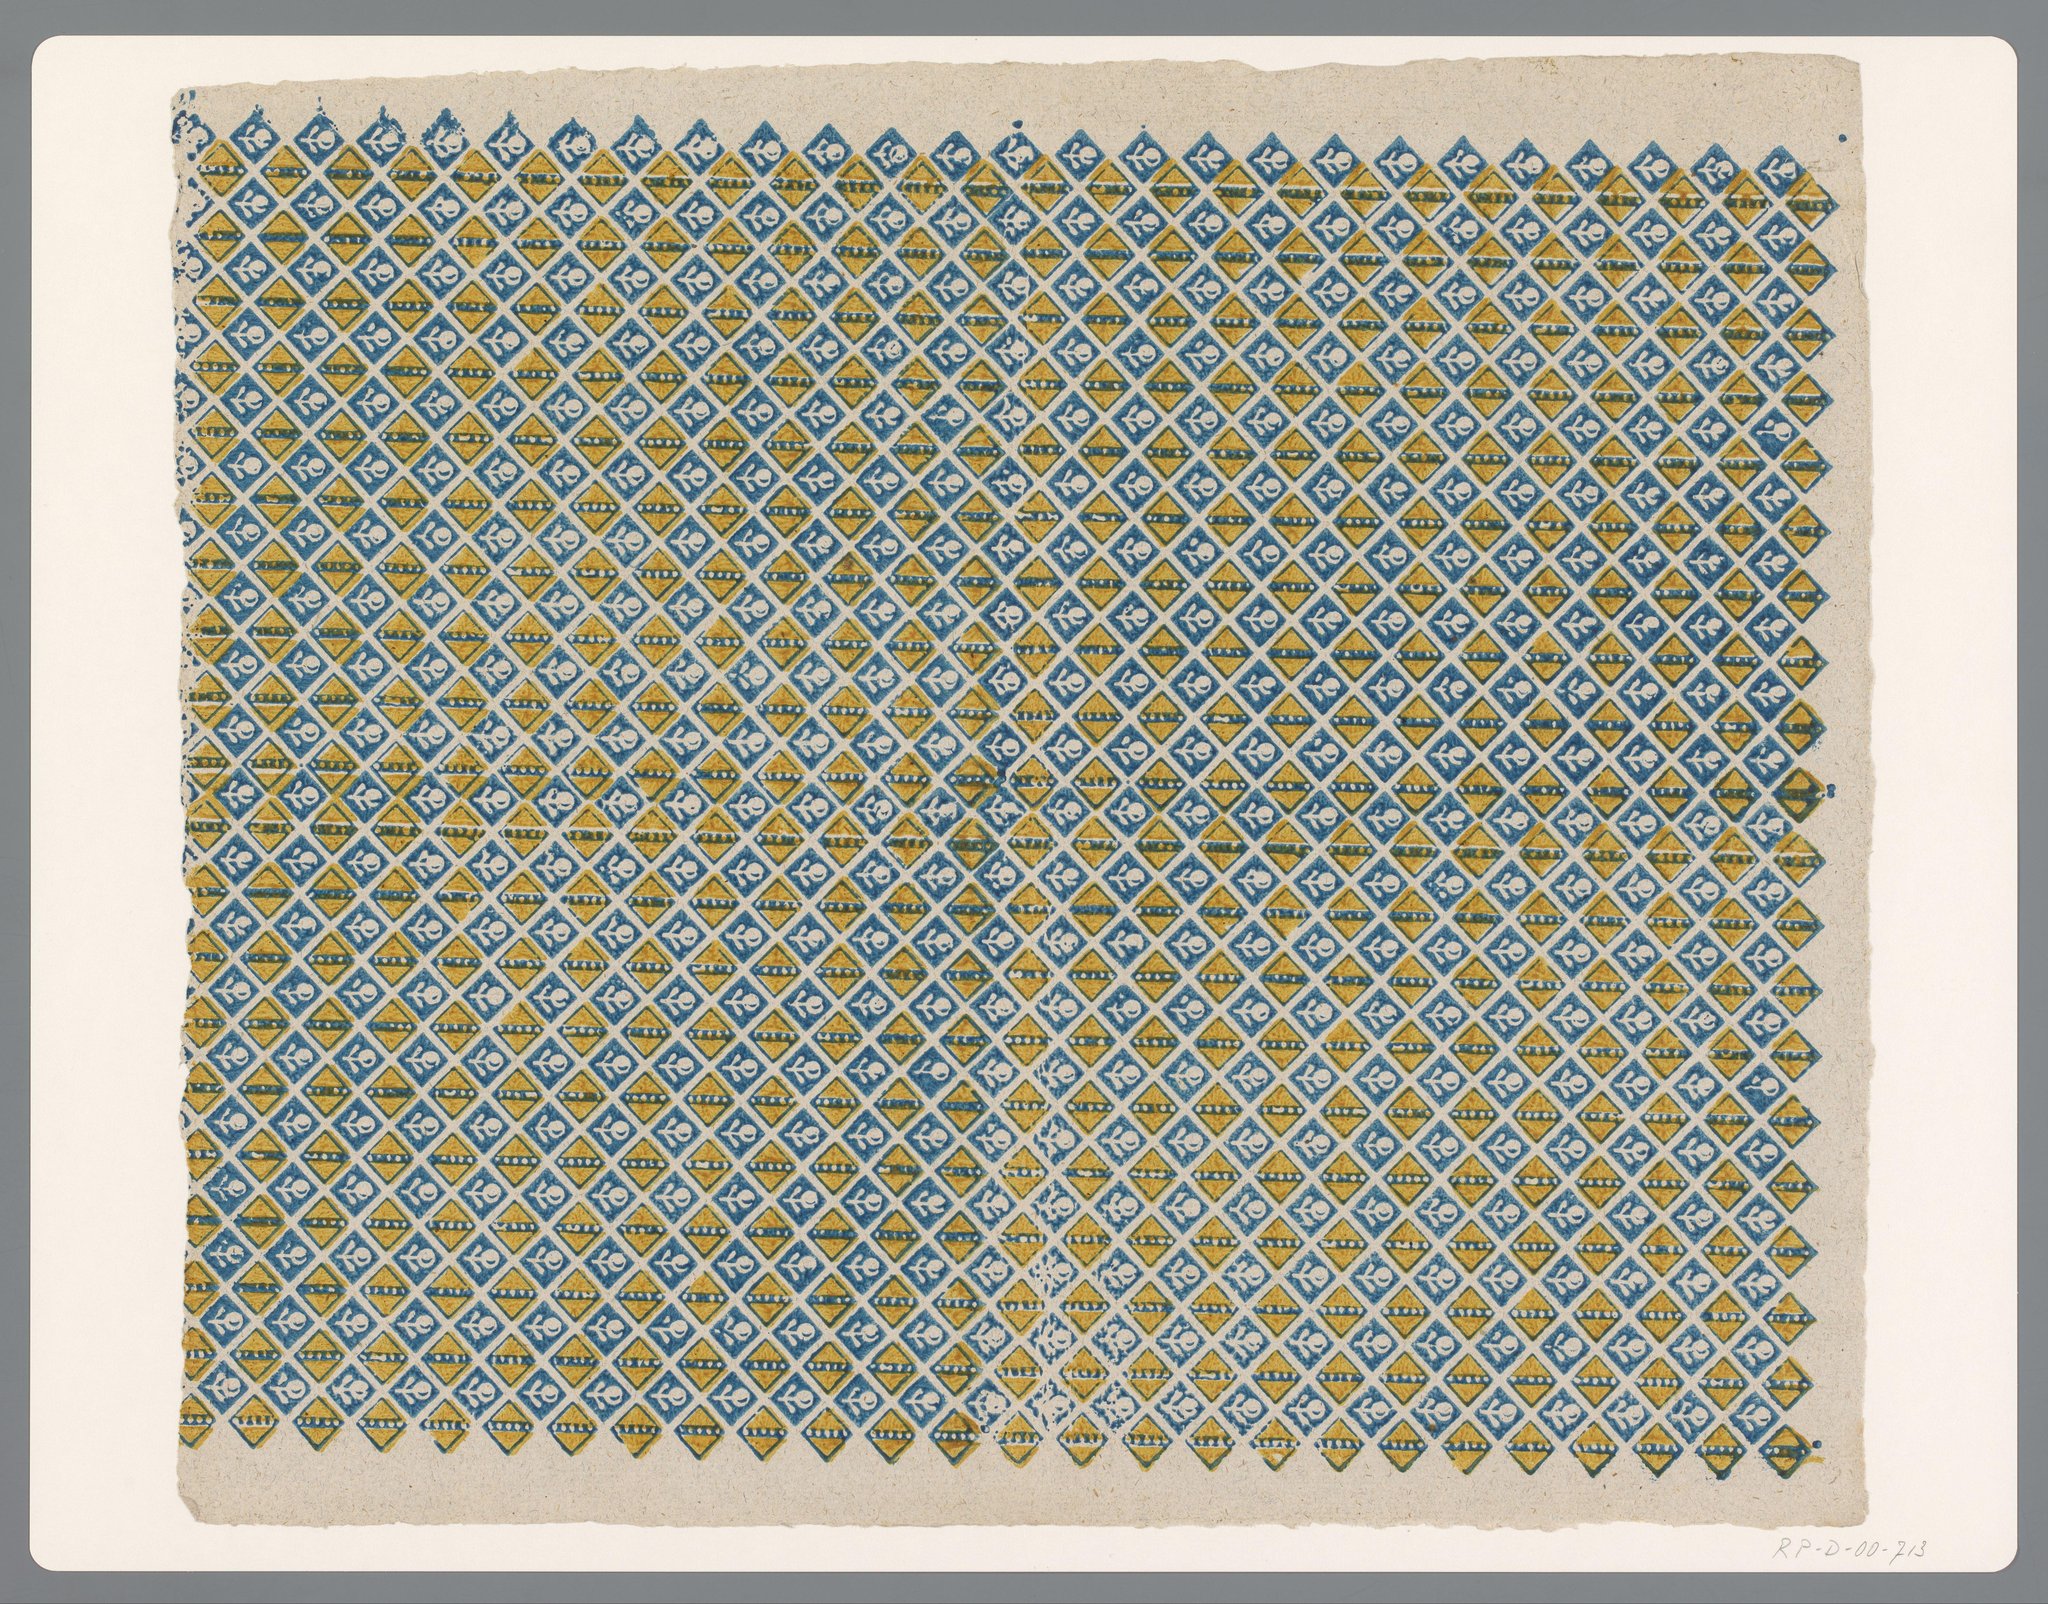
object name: printed paper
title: Blad met ruitenpatroon met uitgespaard bloemmotief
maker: Anonymous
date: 1750-1900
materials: paper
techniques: printing block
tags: ornament derived from plant forms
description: Blad met ruitenpatroon met uitgespaard bloemmotief.